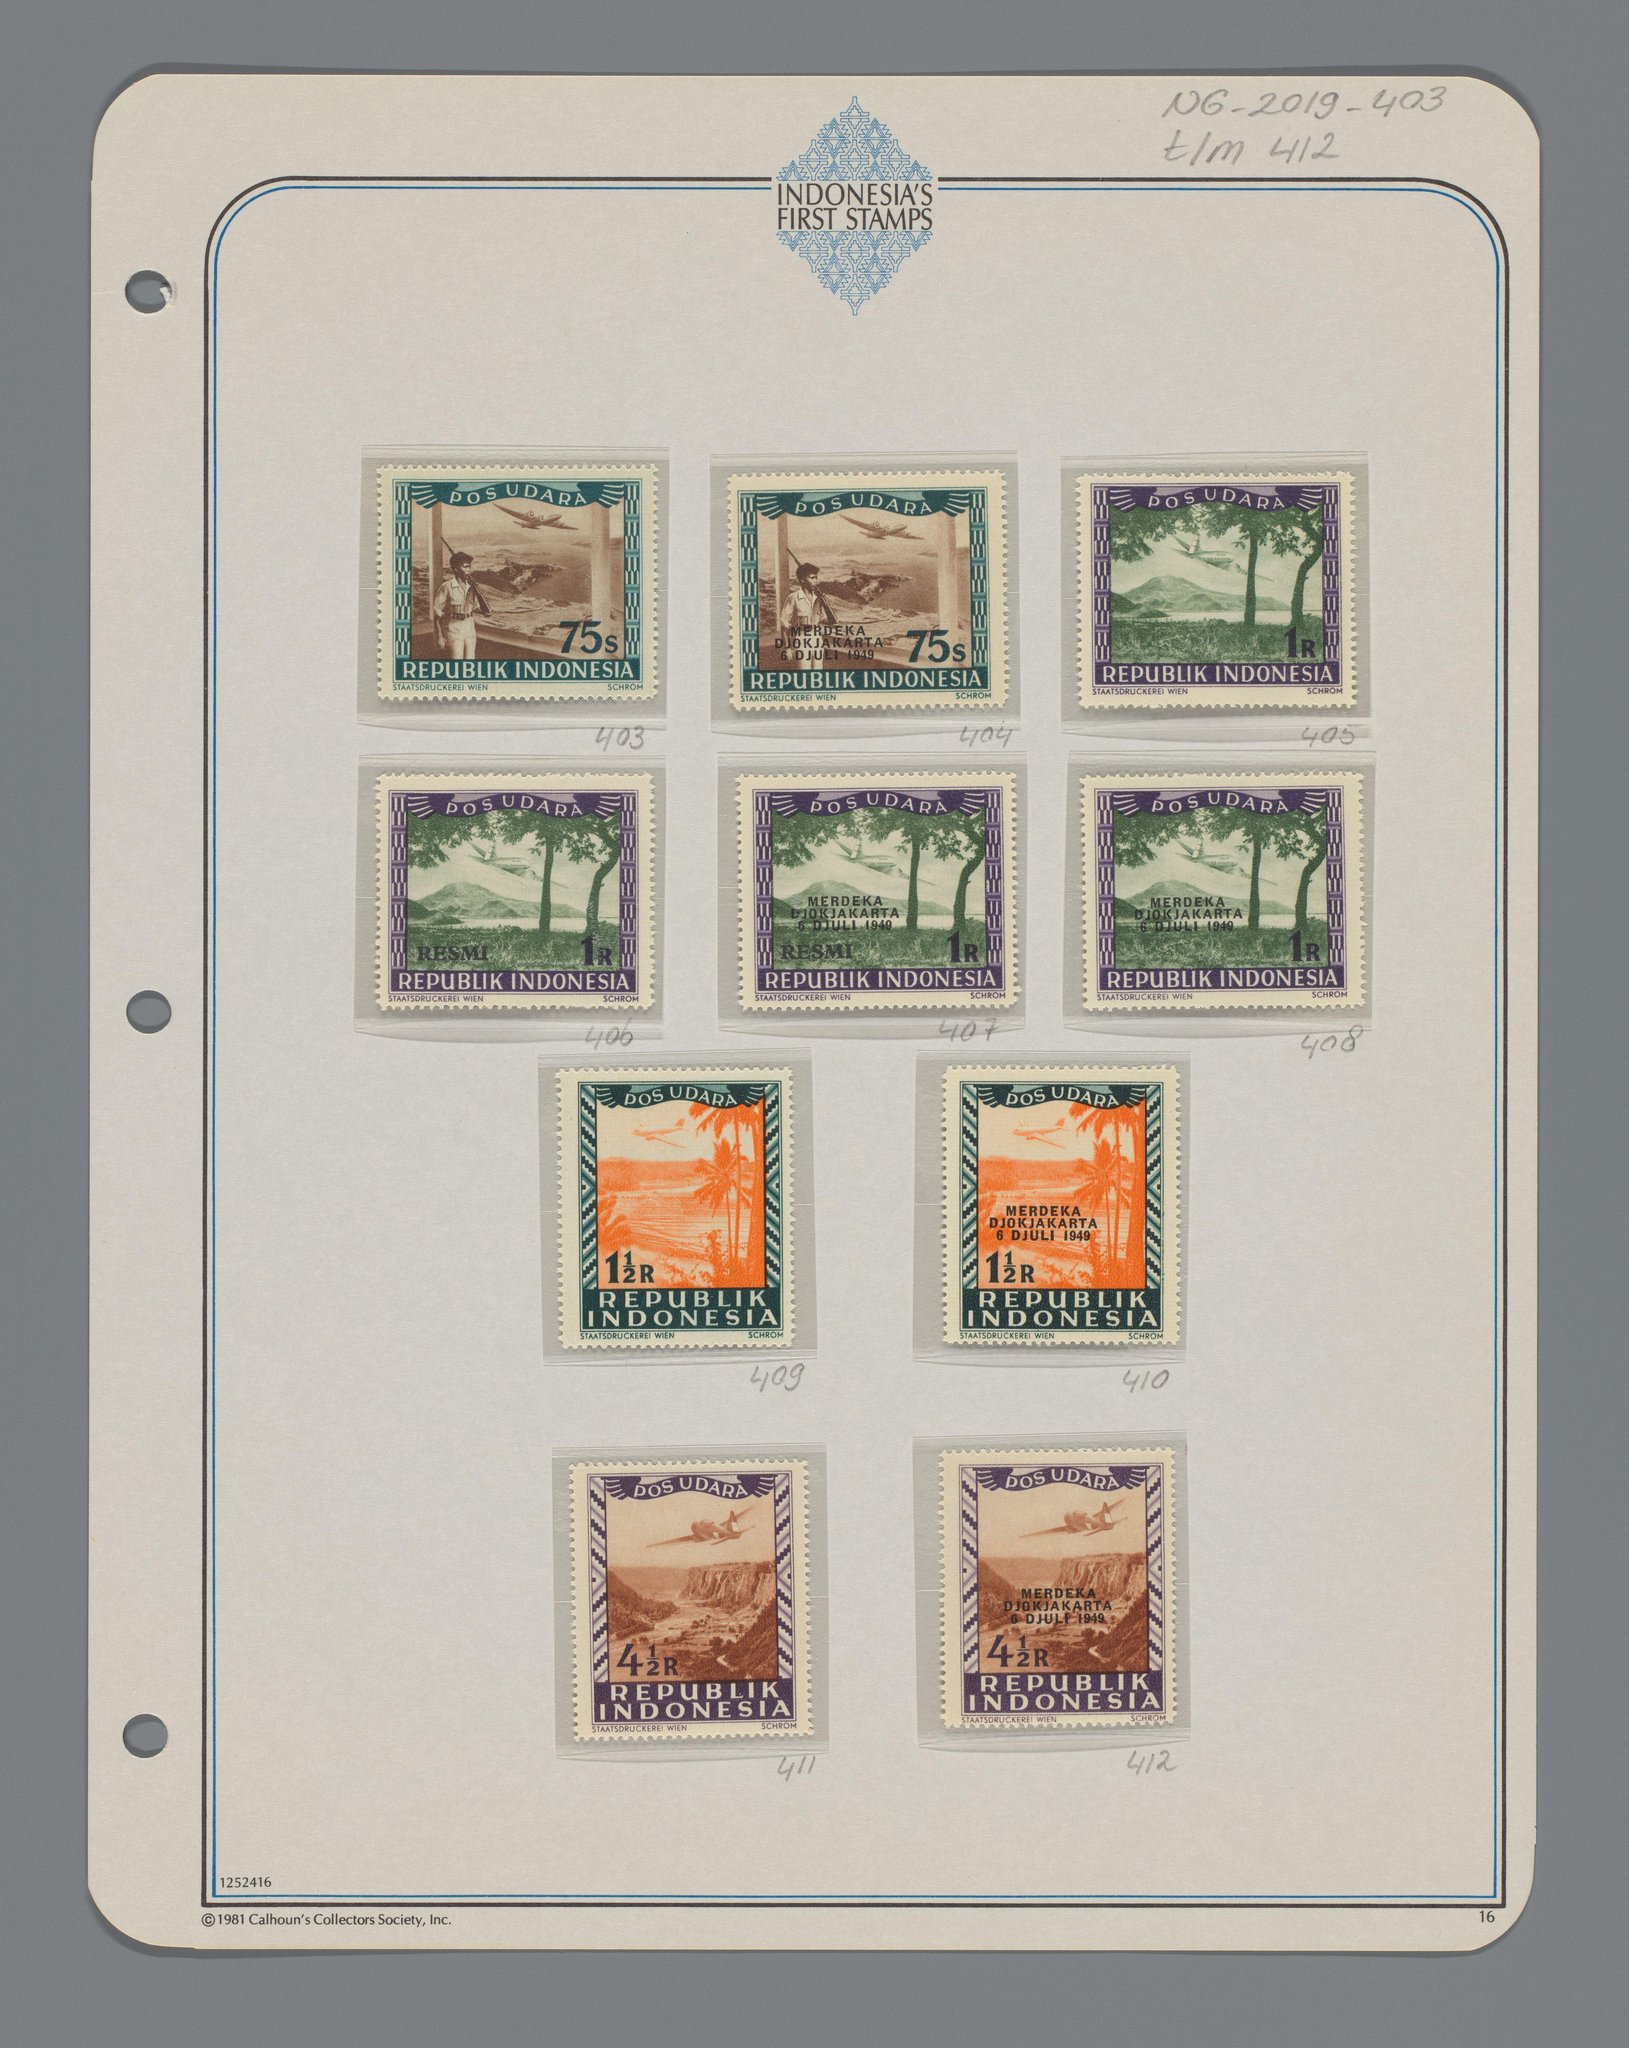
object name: postage stamp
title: Postzegel Republik Indonesia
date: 1949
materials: paper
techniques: photoaquatint, engraving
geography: vienna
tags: indonesia